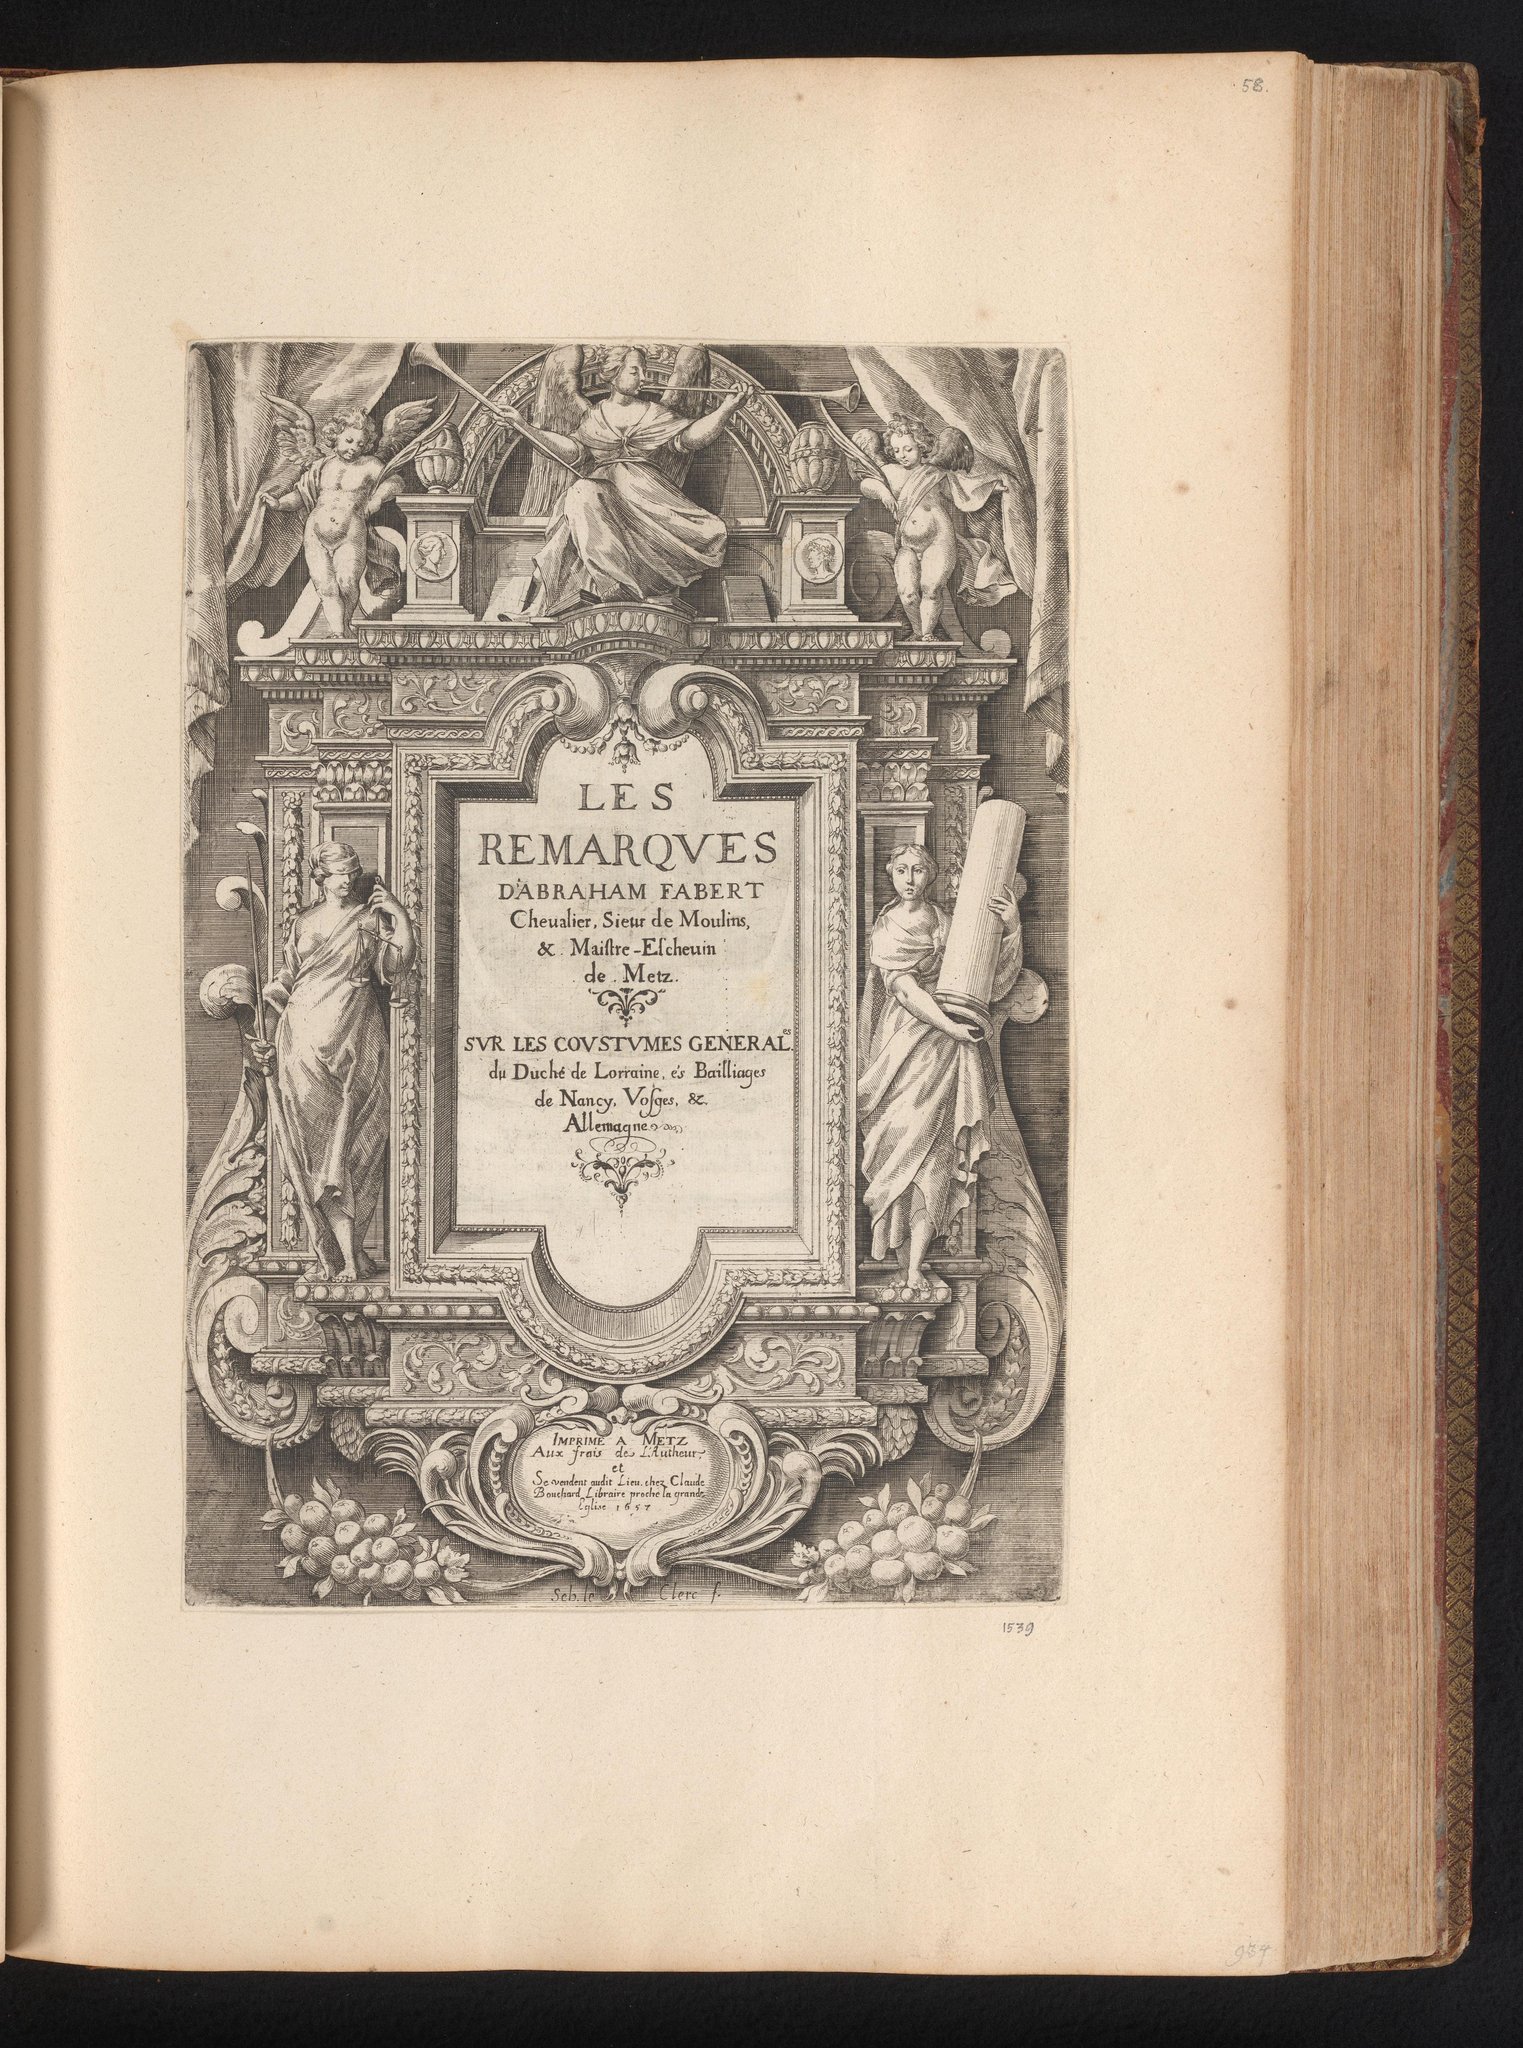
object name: titelblad, titelpagina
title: Lijstwerk met personificaties van Kracht en Rechtvaardigheid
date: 1657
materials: paper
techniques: etching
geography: metz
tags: justitia (justice) as roman personification, strength, power; 'fortezza', 'fortezza d'animo e di corpo', 'fortezza del corpo congiunta con la generosità dell'animo', 'fortezza & valore del corpo congiunto con la prudenza & virtù del animo', 'forza' (ripa)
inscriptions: date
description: Titelpagina voor: Fabert, Abraham. Les Remarques d'Abraham Fabert (...). Metz: Claude Bouchard, 1657.